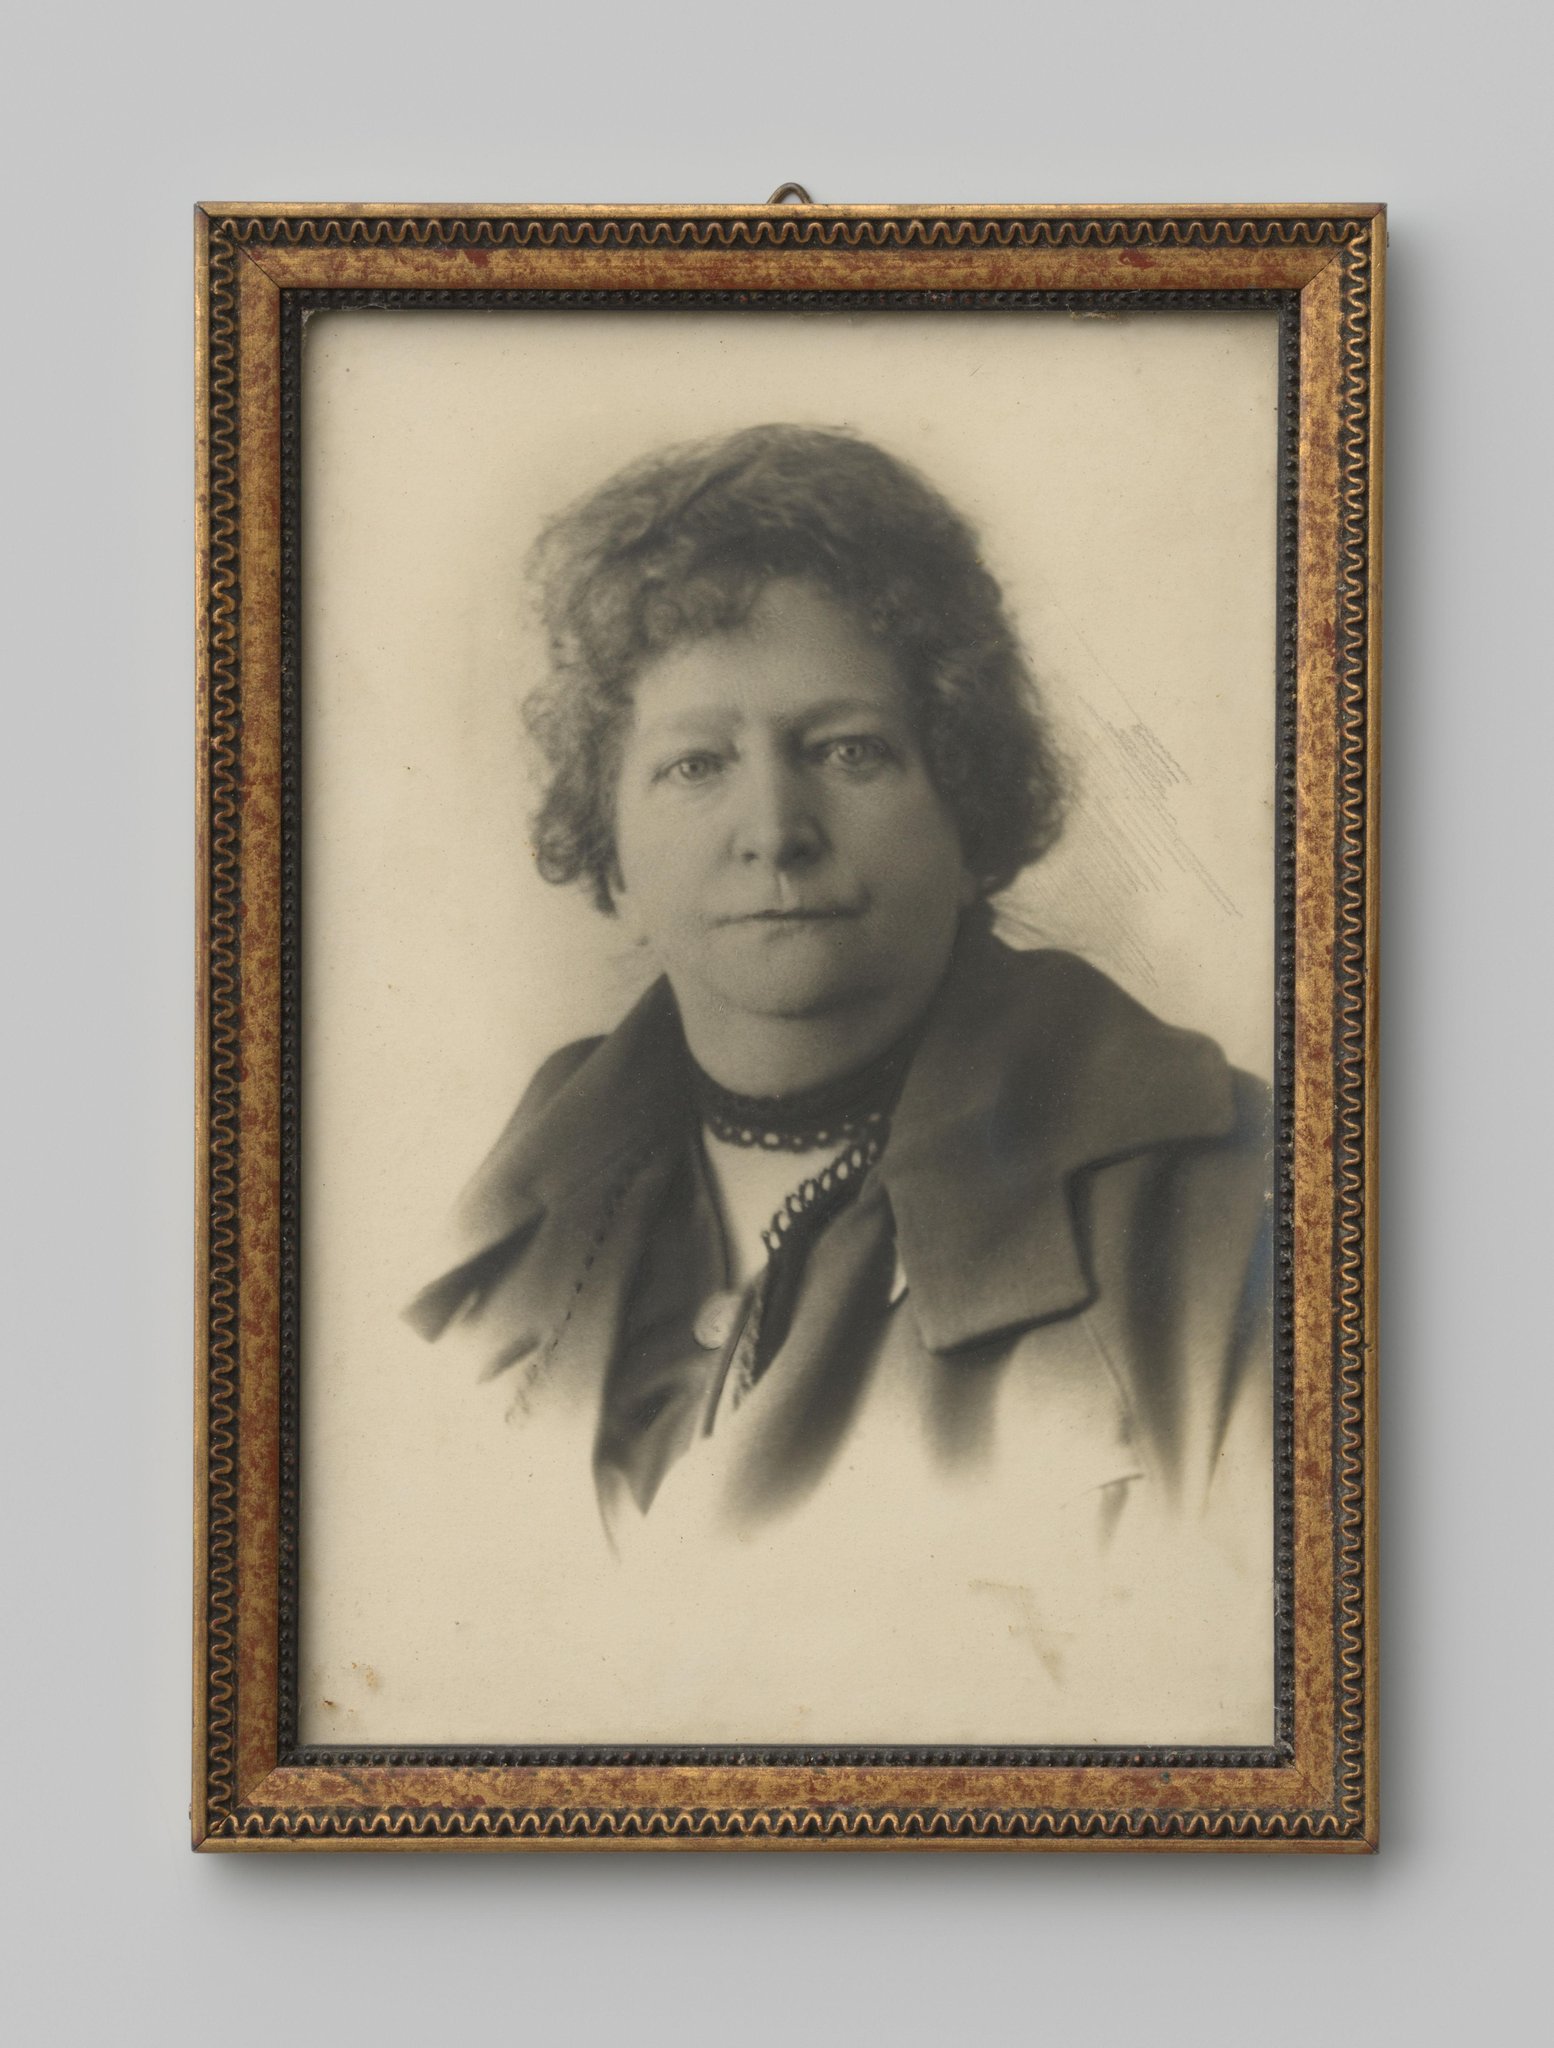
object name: frame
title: Portret van de actrice Magda Janssens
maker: Anonymous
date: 1925-1935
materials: paper, cardboard, glass, metal, wood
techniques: gelatin silver print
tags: antwerp, amsterdam, portrait of actor, actress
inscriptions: inscription: ‘Magda Janssens geb 1884 overl/ Nederlands toneelspeelster, geboren in Antwerpen/ waar zij in 1902 in de Vlaamse schouwburg/ debuteerde./ In 1914 week zij uit naar Nederland/ en kwam in het gezelschap van Willem Royaards/ tot 1926. Later nog bij Verkade [...] v.d. [...]’